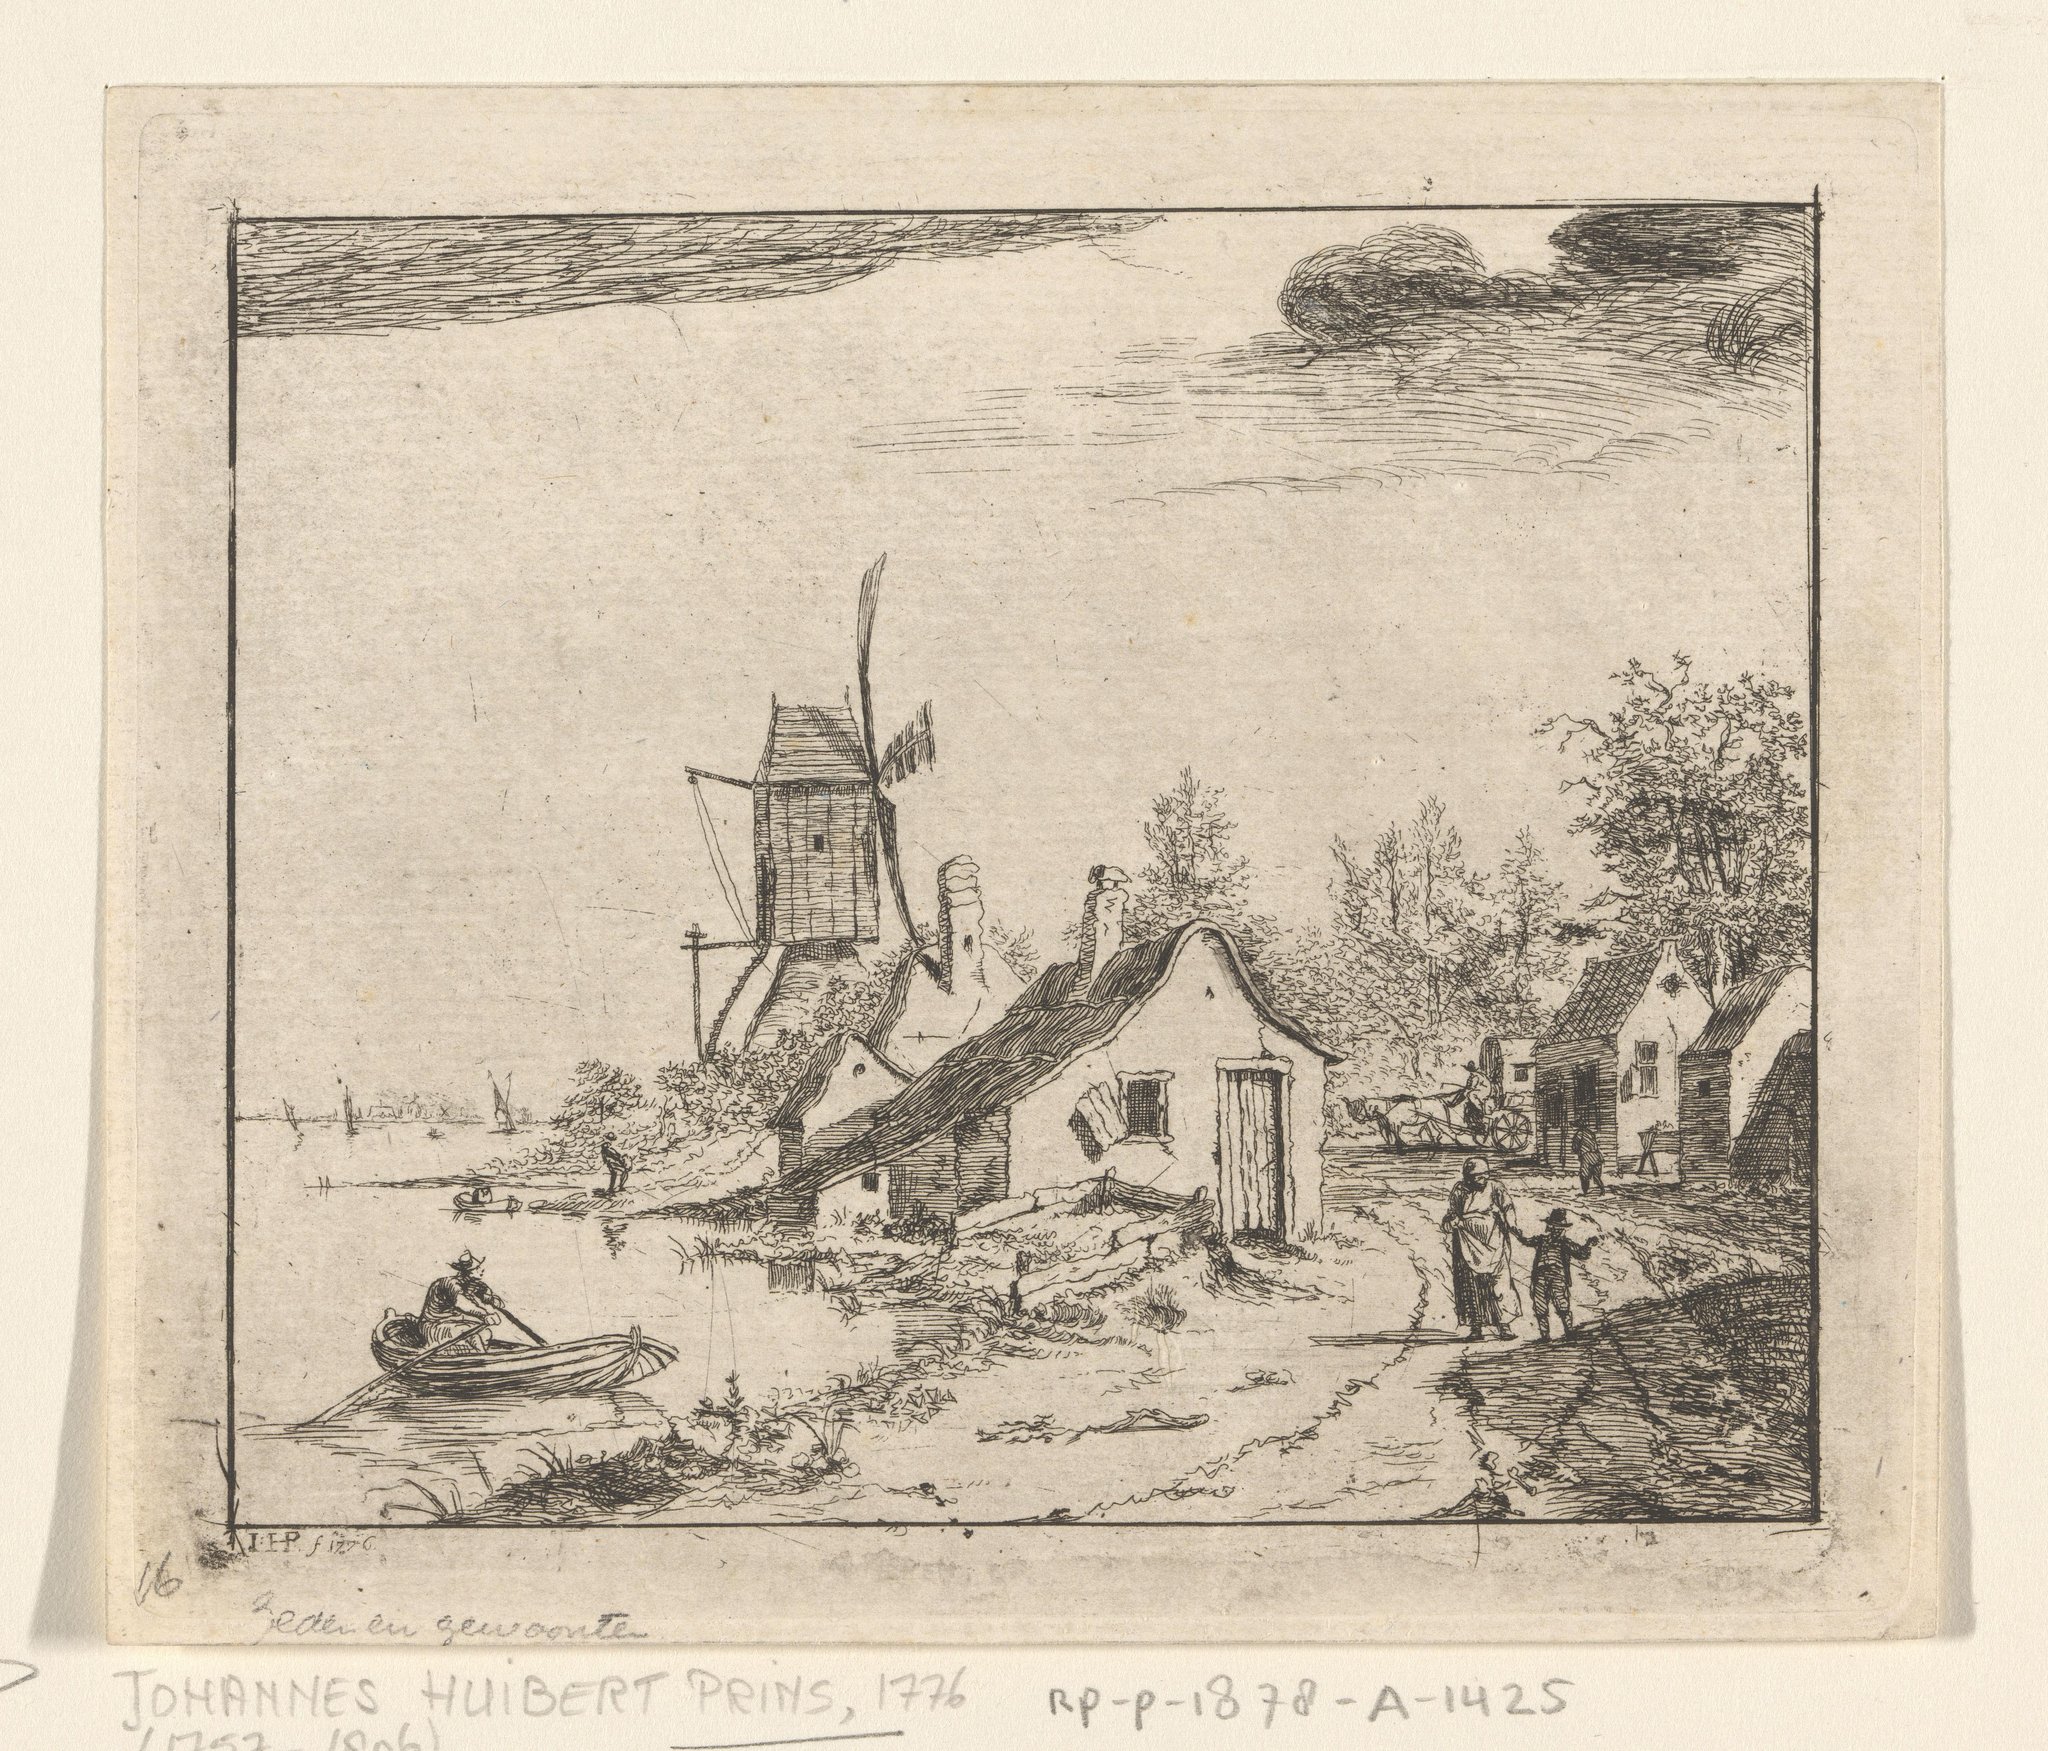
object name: print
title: Dorp aan een rivier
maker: johannes huibert prins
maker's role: draughtsman, painter, print maker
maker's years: 1757-1806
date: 1776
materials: paper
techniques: etching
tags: rowing-boat, canoe, etc., windmill, outskirts of village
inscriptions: collector's mark: Lugt 2228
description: Een dorp met stenen huizen en een molen aan een rivier waarop een man in een roeiboot vaart. Op de straat een vrouw met kind en een paard en wagen.